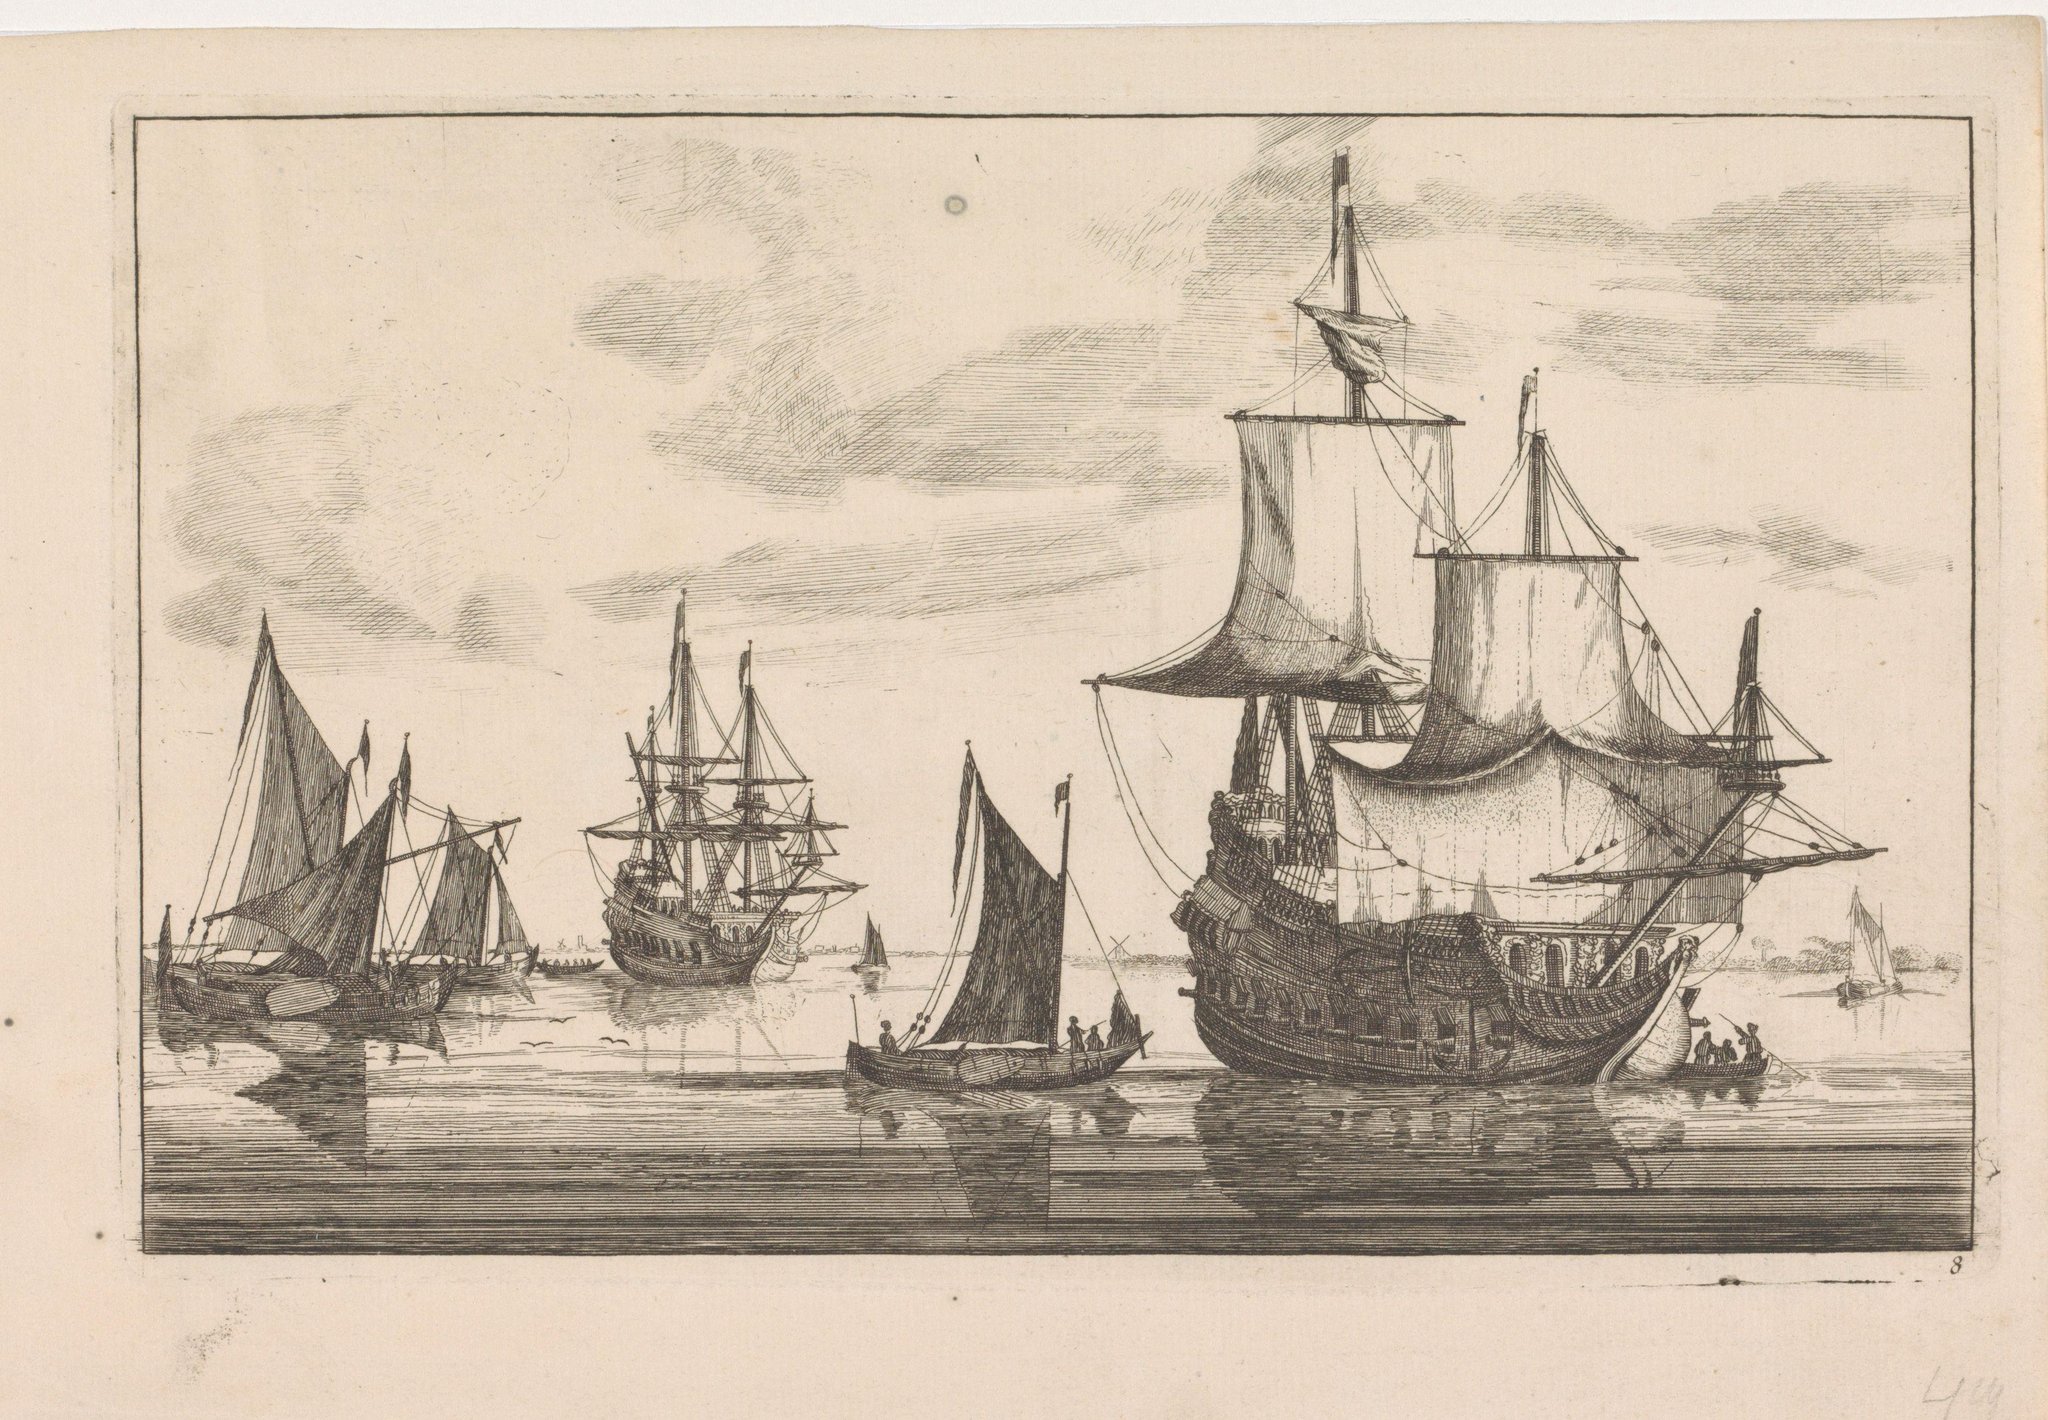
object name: print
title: Zeegezichten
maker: Anonymous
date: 1600-1700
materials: paper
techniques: engraving, etching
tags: sailing-ship, sailing-boat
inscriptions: inscription: ‘FM 1884’